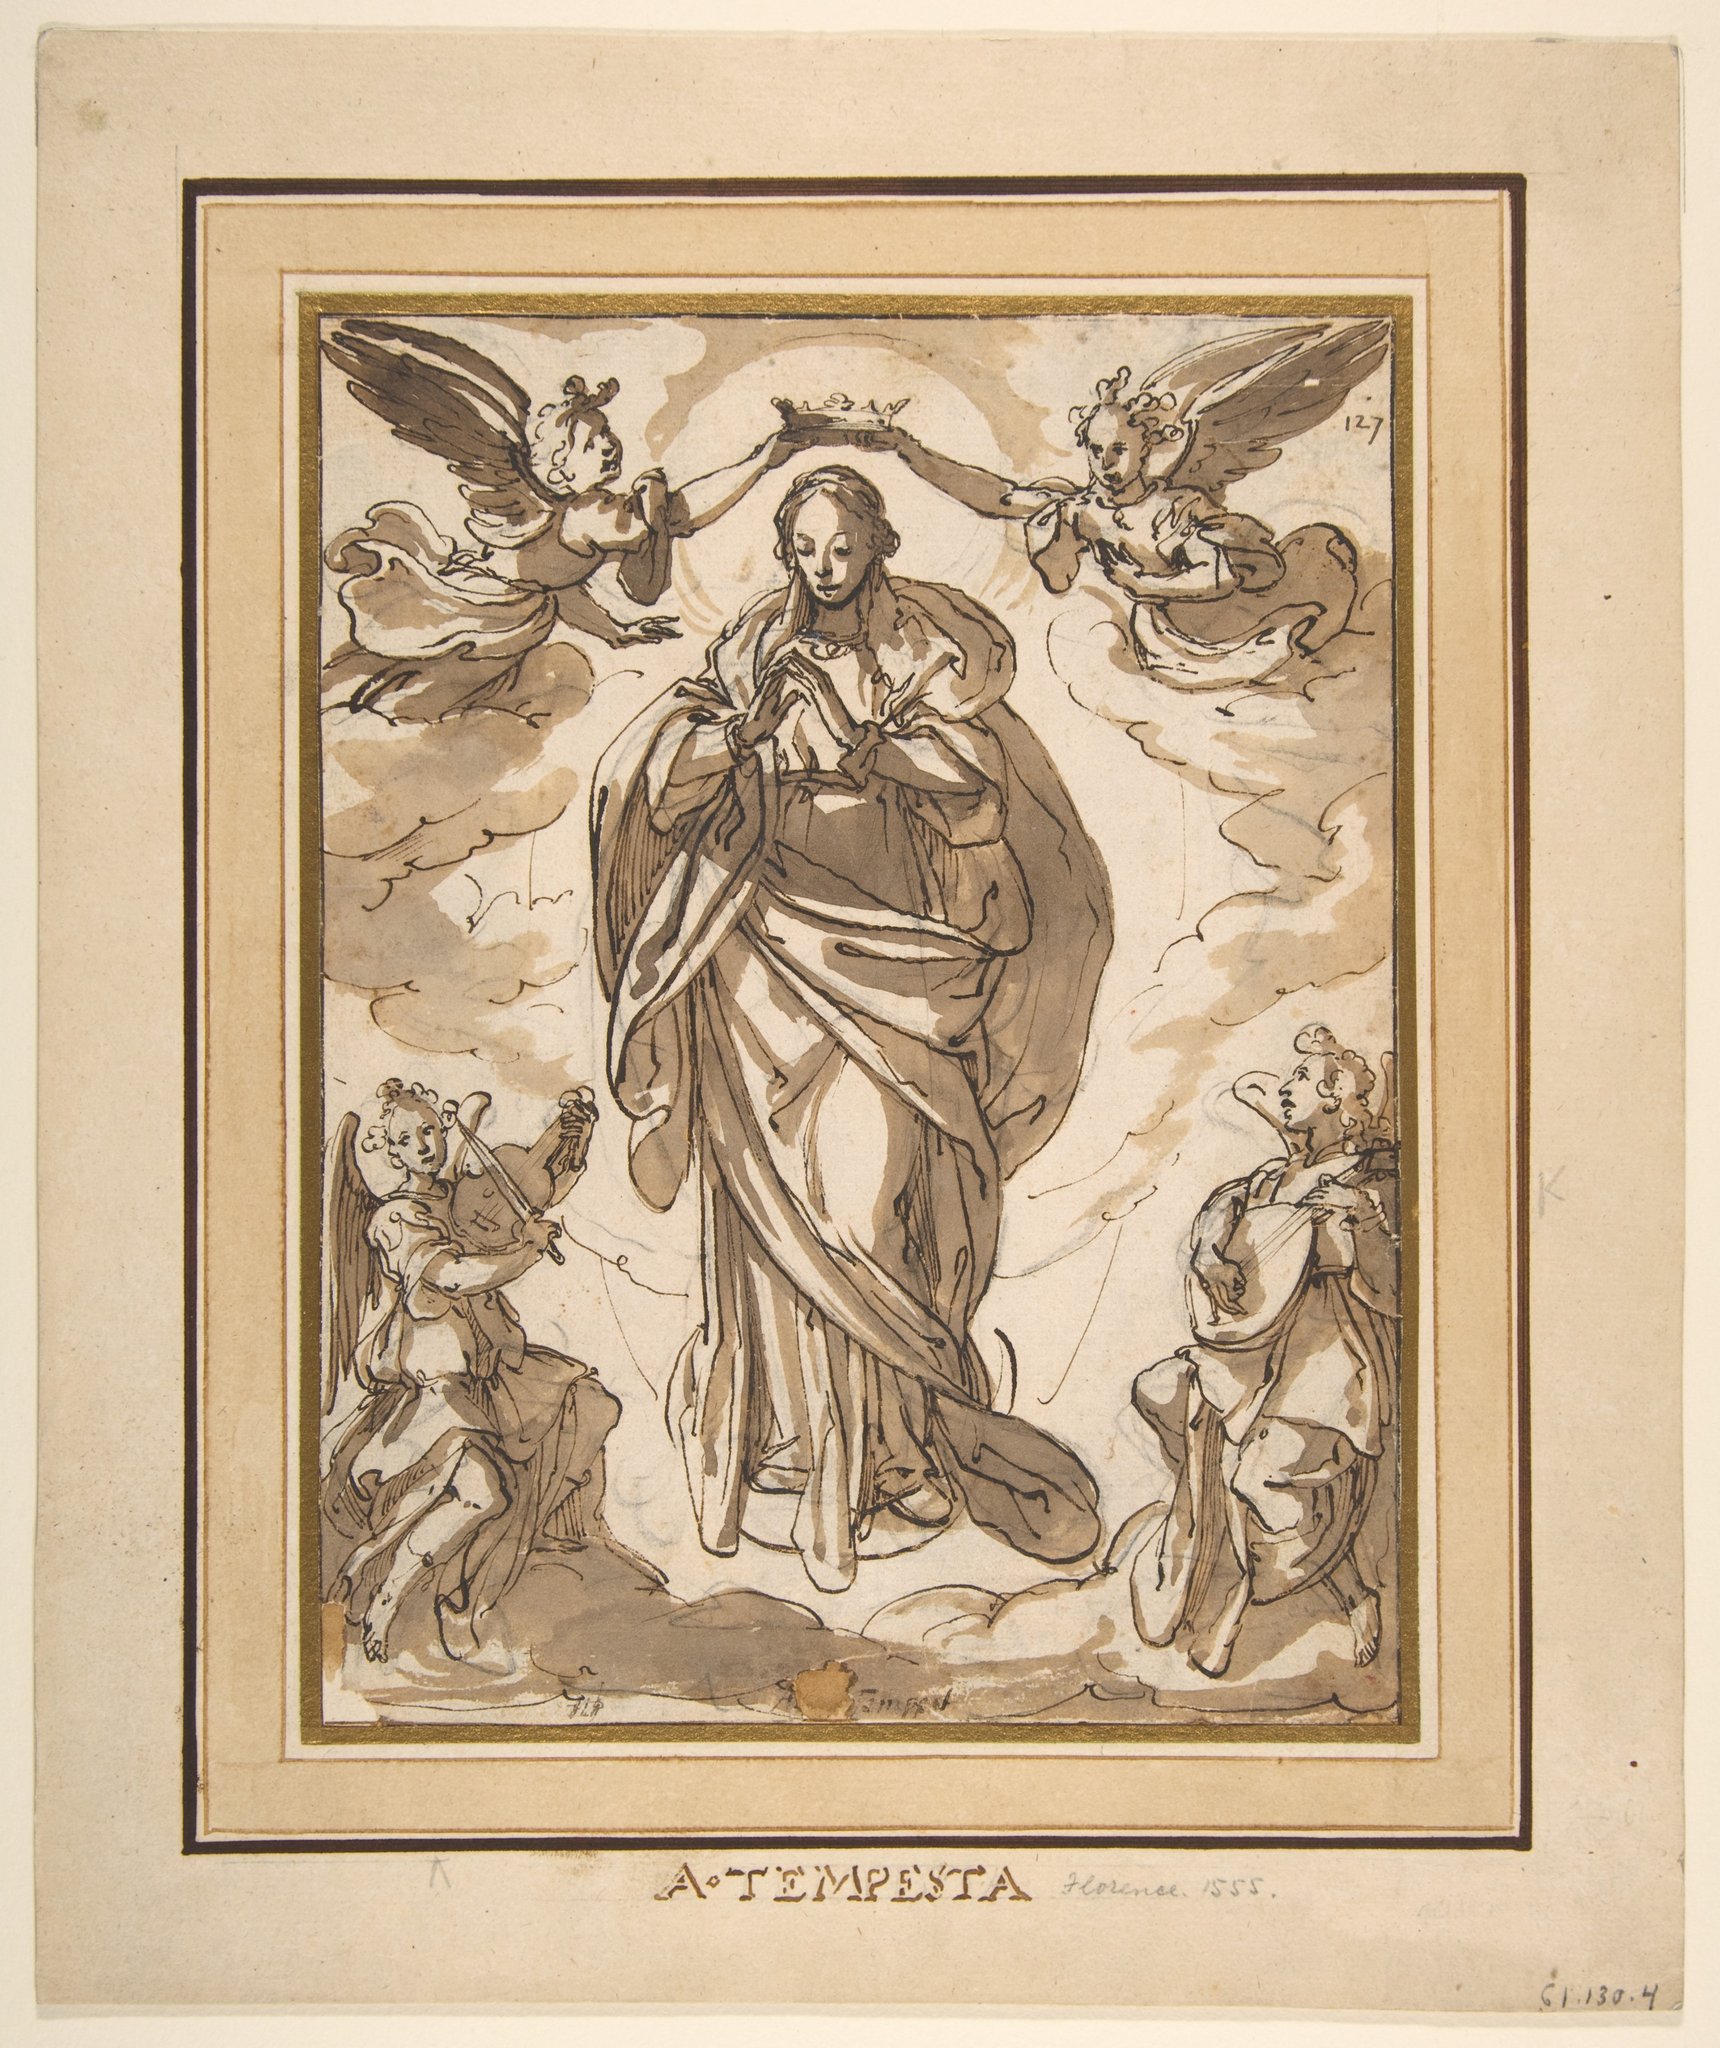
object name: drawing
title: The Virgin Immaculate Crowned by Two Angels, with Angel Musicians in the Foreground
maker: domenico fontana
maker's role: artist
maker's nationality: italian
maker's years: 1555-1630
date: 1555-1630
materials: chalk, ink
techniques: pen, wash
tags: angels,virgin mary,musicians